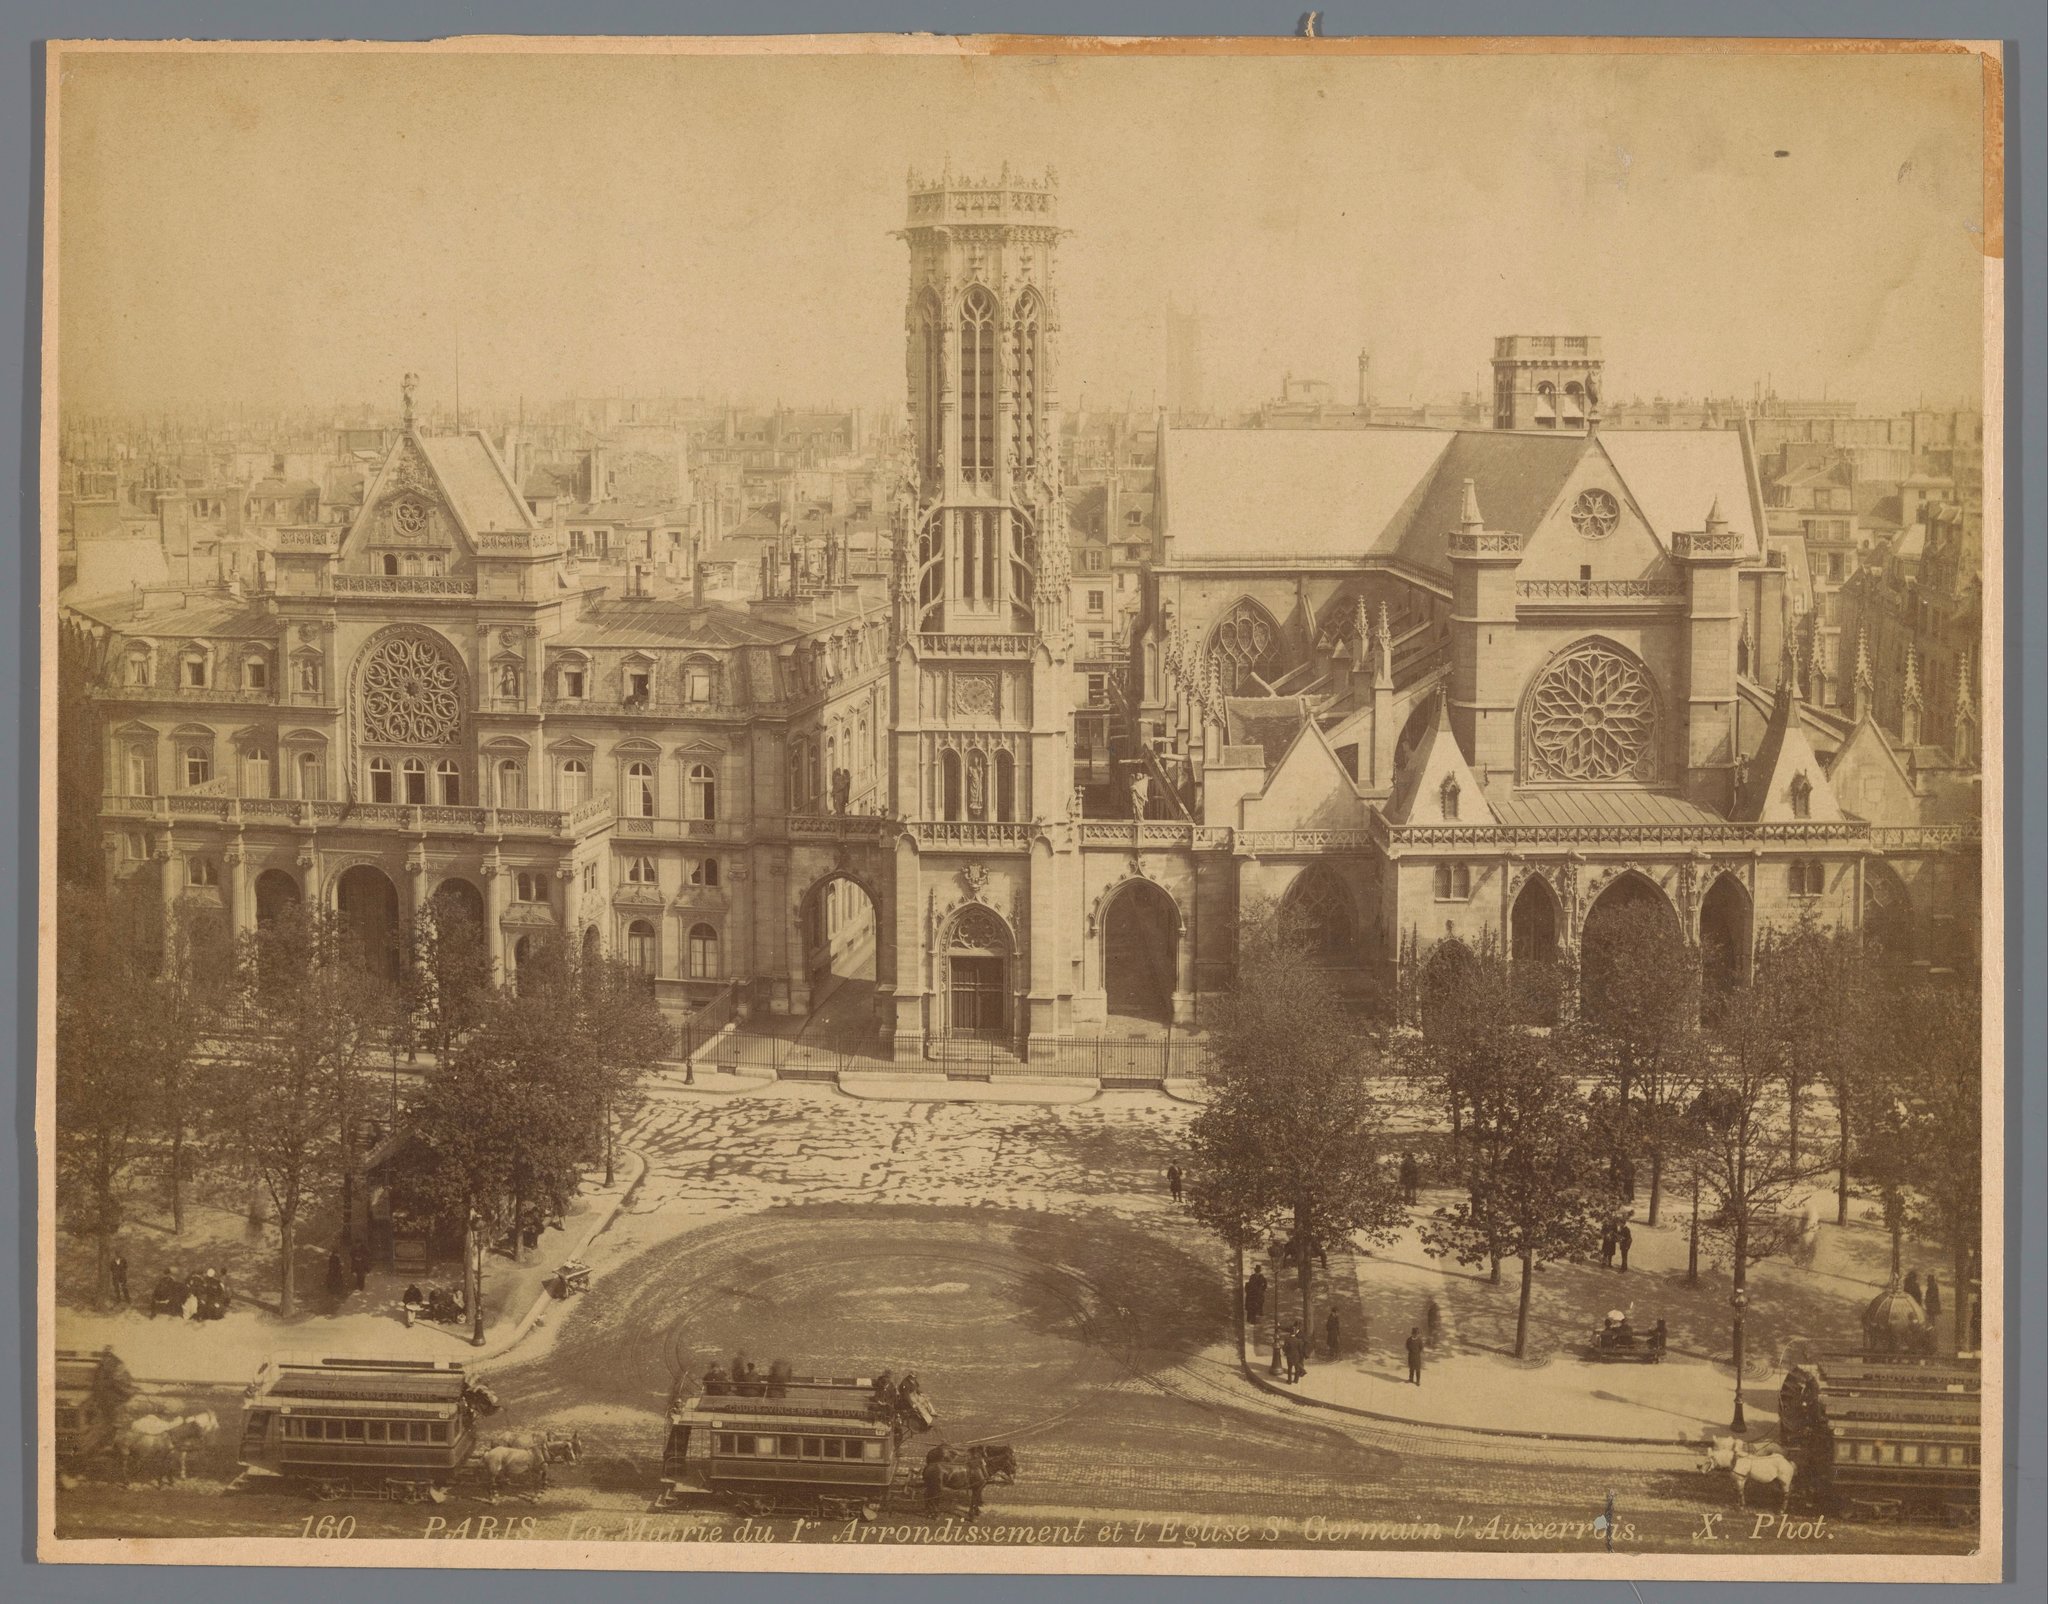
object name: photograph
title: Paris. La Mairie du 1er Arrondissement et l'Église St. Germain l'Auxerrois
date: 1887-1900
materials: cardboard, paper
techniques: albumen print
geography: paris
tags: square, place, circus, etc., diligence, omnibus, horse-tram, church (exterior), townhall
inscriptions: inscription: ‘160 Paris. La Mairie du 1er Arrondissement et l'Église St. Germain l'Auxerrois. X. Phot.’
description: Tussen 1887 en ca. 1900 werkten Neurdein frères onder andere onder de naam 'X phot.'.